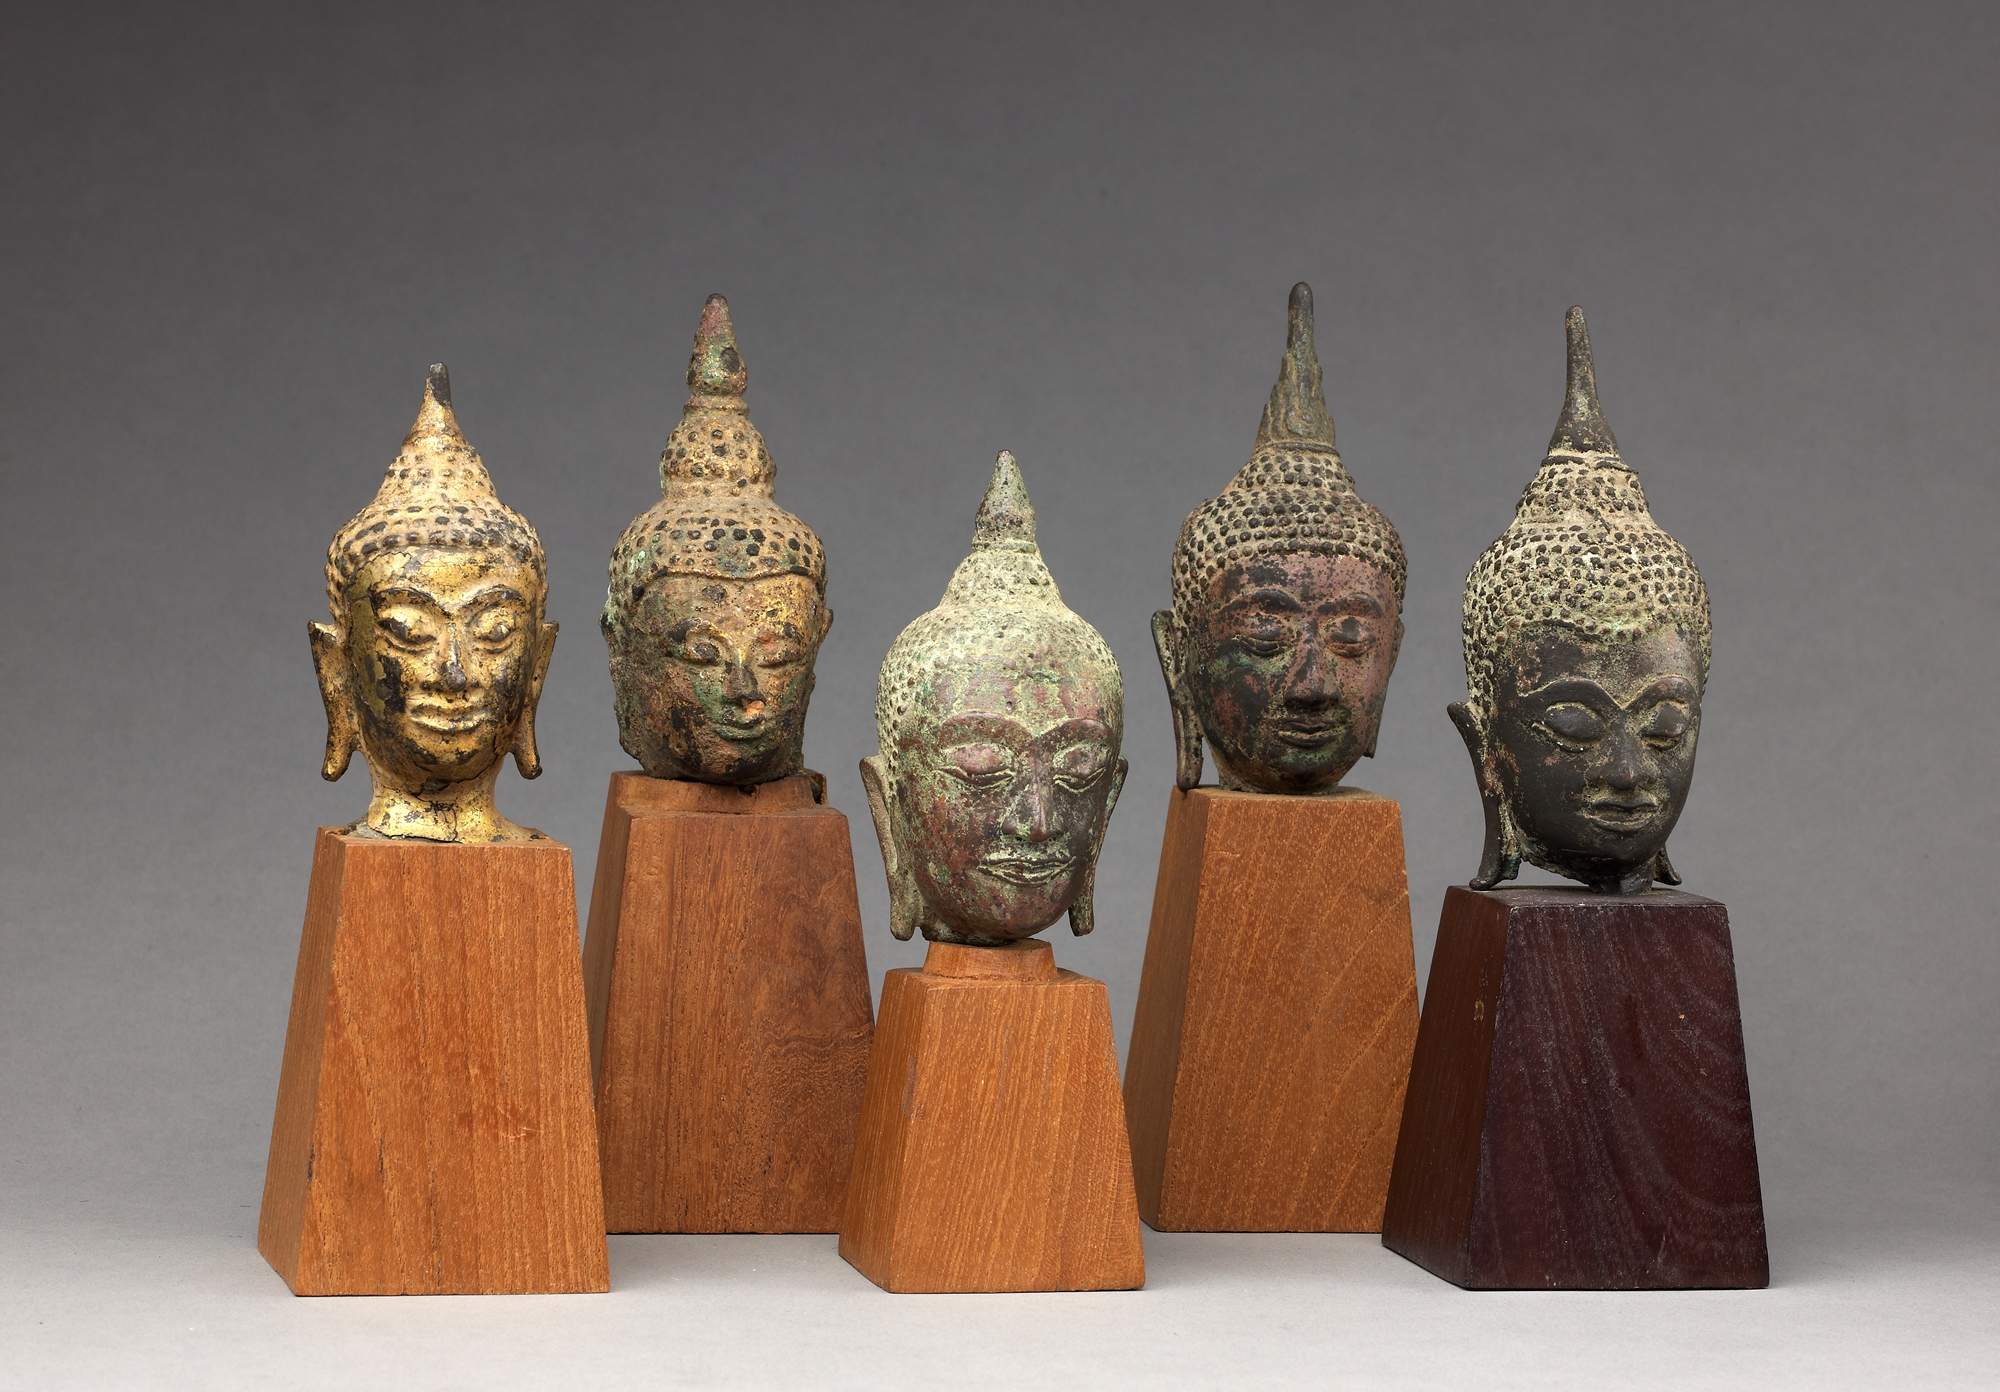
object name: sculpture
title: Head of the Buddha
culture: thai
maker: thai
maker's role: artist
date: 1767-1900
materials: copper alloy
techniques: gilding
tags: heads,buddha